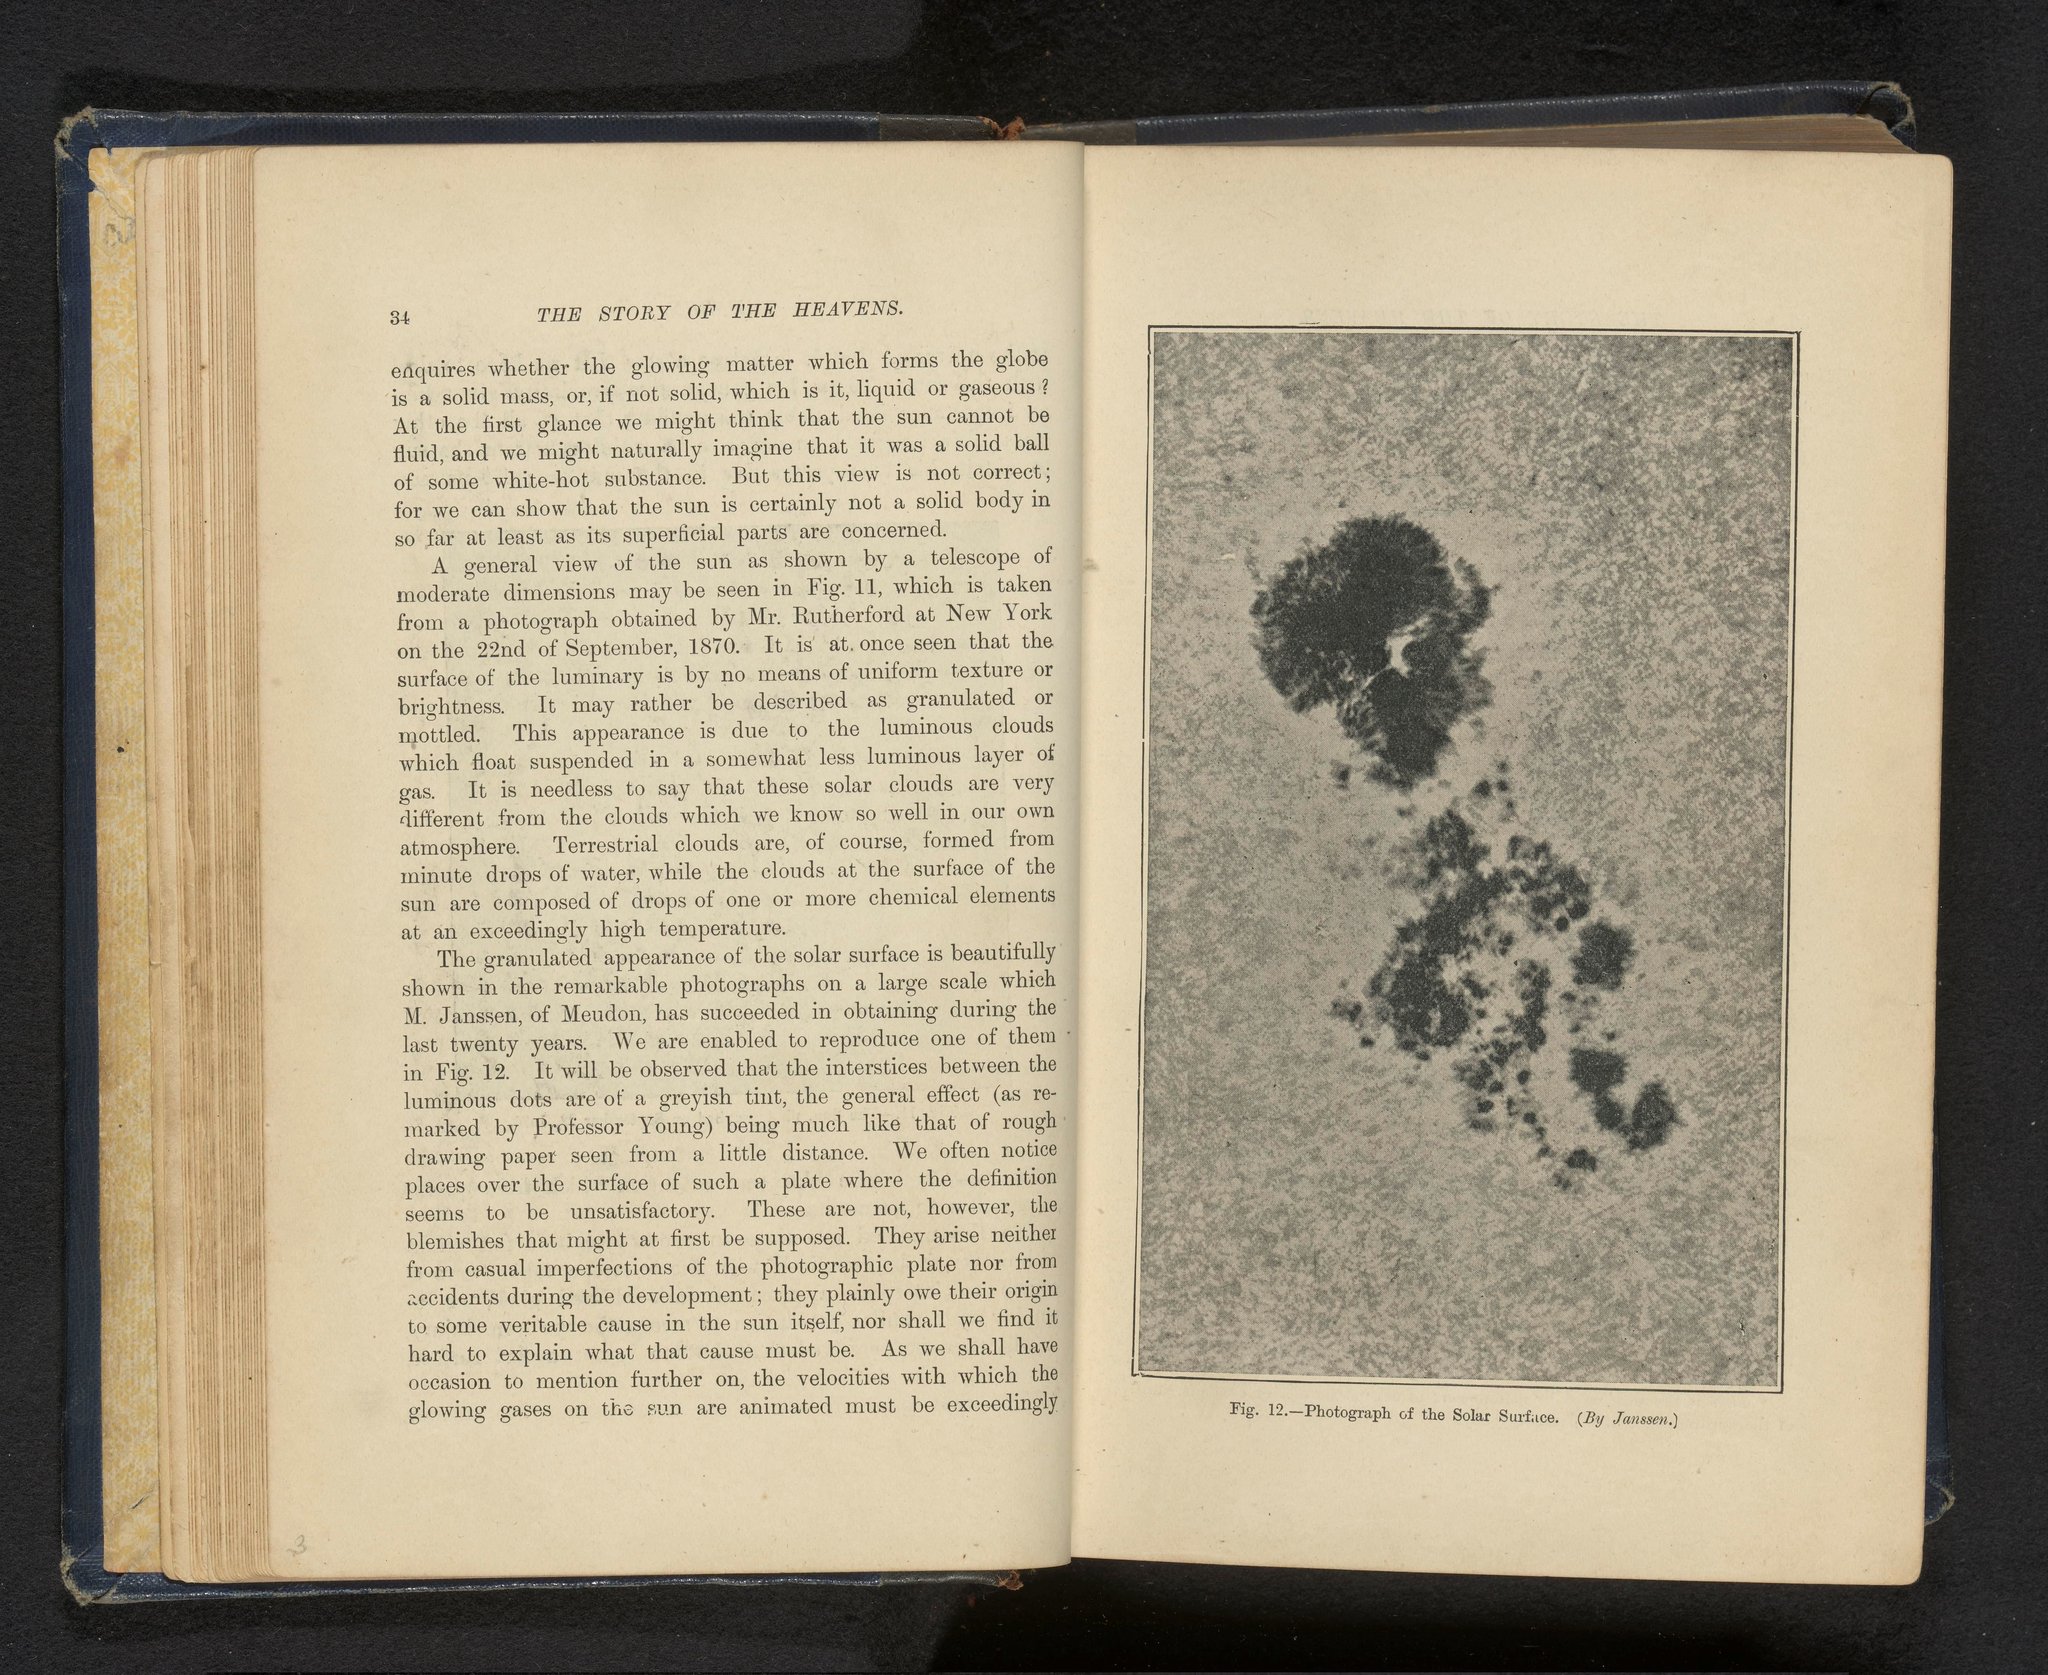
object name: page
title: Oppervlak van de zon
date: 1891-1901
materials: paper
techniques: autotype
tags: sun-spots, sun as celestial body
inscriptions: inscription: ‘Photograph of the Solar Surface.’, number: ‘Fig. 12.’